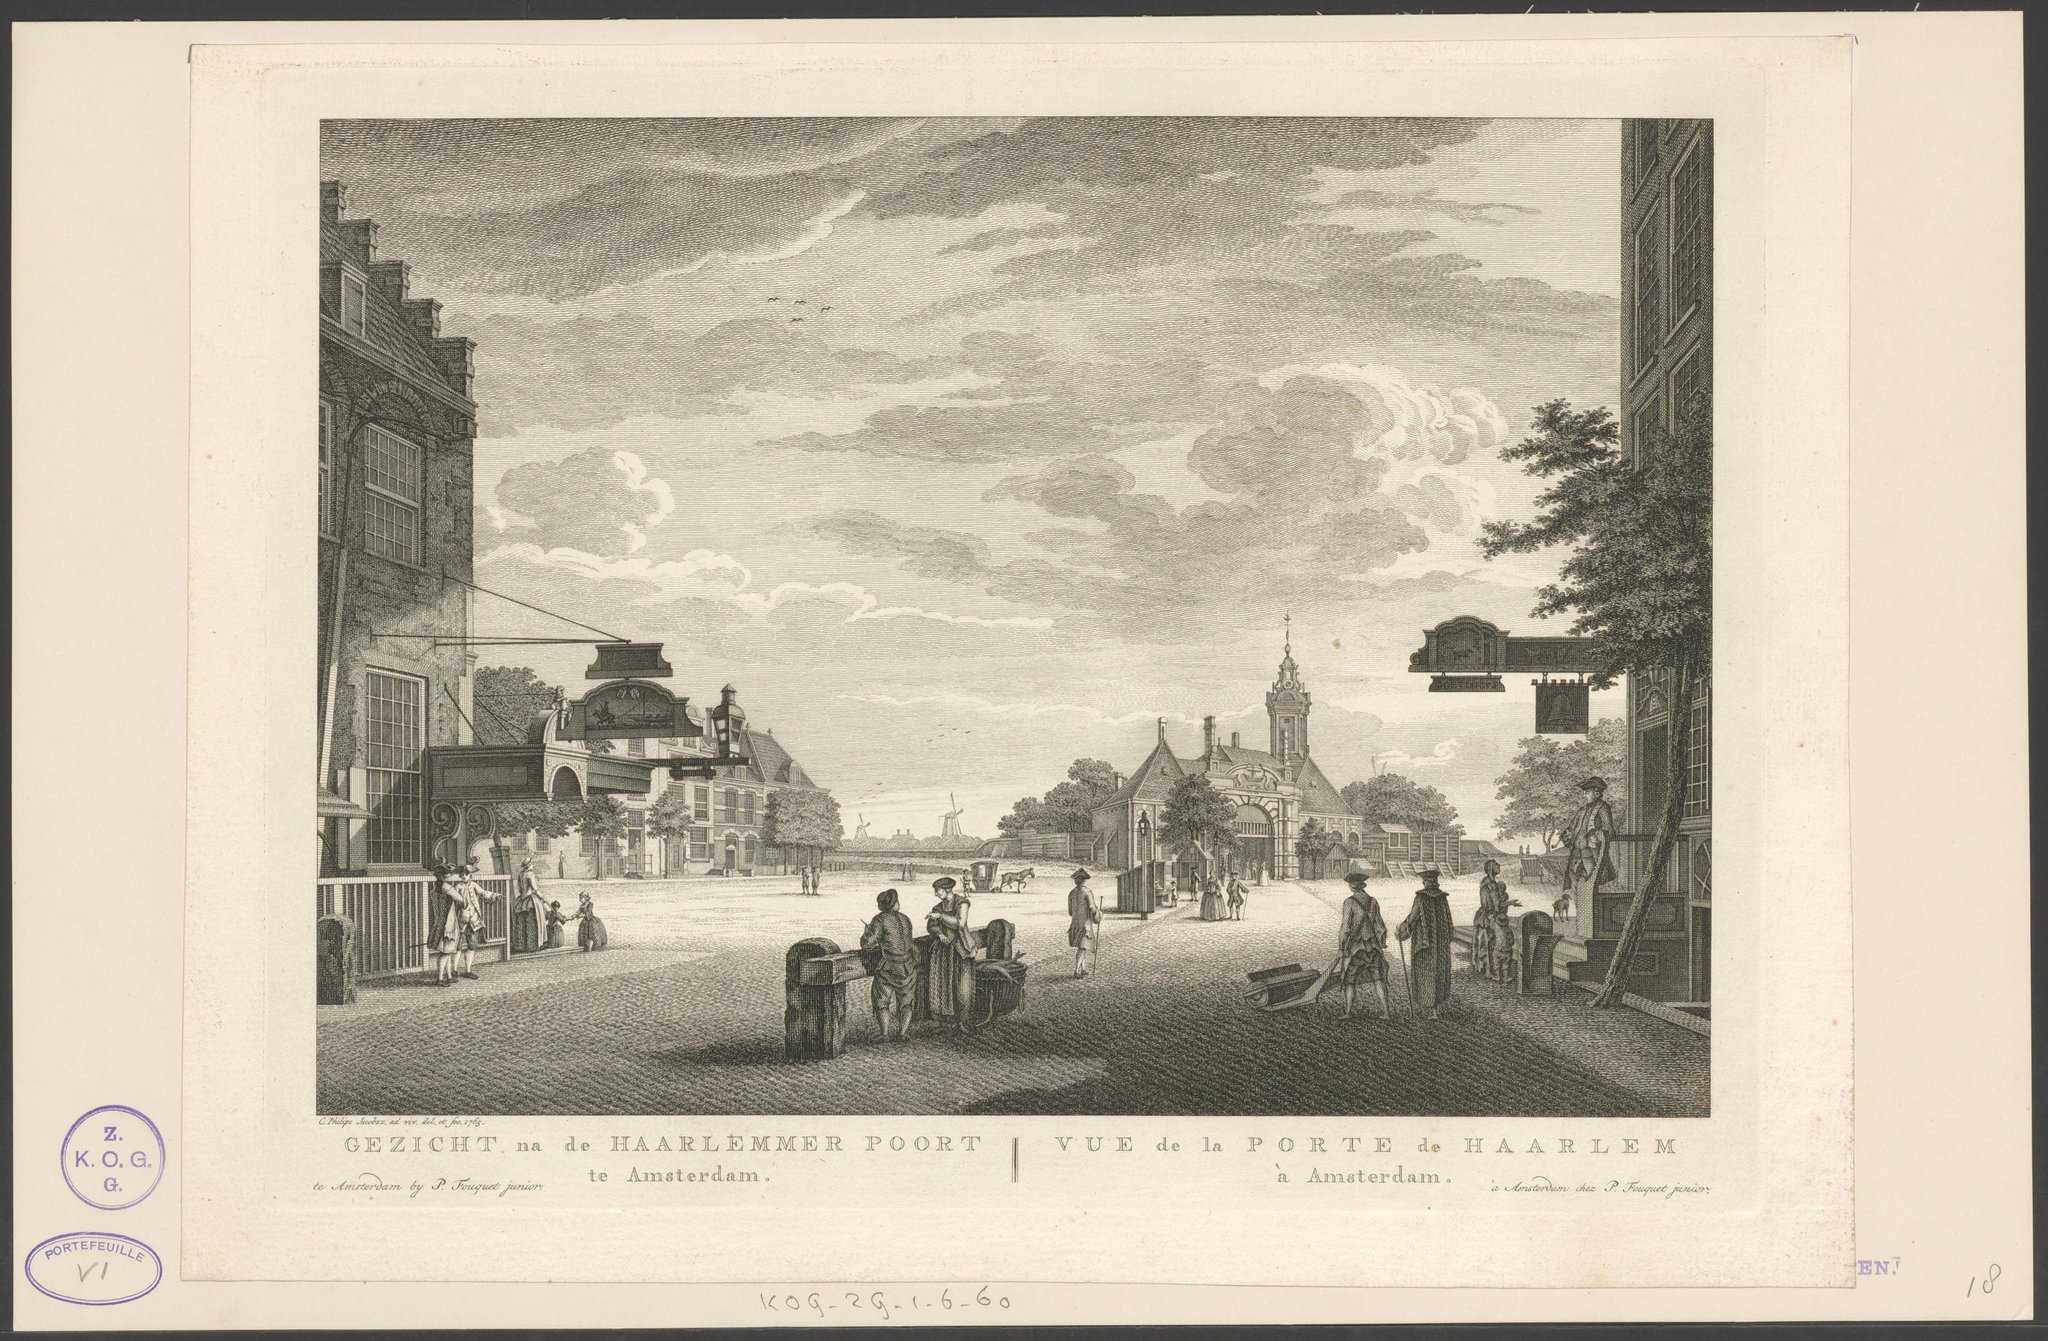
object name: print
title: Gezicht na de Haarlemmer Poort te Amsterdam / Vue de la Porte de Haarlem à Amsterdam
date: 1760-1783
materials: paper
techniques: engraving, etching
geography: amsterdam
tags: village street, city-gate, amsterdam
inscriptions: stamp, collector's mark: Lugt 1641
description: Deze prent is ook gebruikt in de zogenaamde Atlas van Fouquet.* Pierre Fouquet gaf vanaf 1760 stadsgezichten van Amsterdam - naar tekeningen van verschillende kunstenaars, gemaakt door verschillende prentmakers - uit. Deze prenten werden aanvankelijk los of in series verkocht. Zoals toen gebruikelijk kon de koper de prenten zelf laten inbinden. Hiertoe gaf Fouquet tussen 1778 en 1783 een titelblad, plattegrond en inhoudsopgave van de tot dusver 100 uitgegeven prenten uit (1). Gezien de inhoud afhankelijk was van wat de koper had verzameld verschilt de inhoud van de verschillende bewaarde Fouquetatlassen onder deze titel sterk. Ook zijn er exemplaren bekend waar tevens andere prenten aan zijn toegevoegd. Omdat er behoefte bleek aan uitleg bij de platen werd in 1783 een nieuwe versie van de atlas uitgegeven, aangevuld met tekst en twee prenten. De aangegeven volgorde veranderde maar de platen van de al eerder uitgegeven prenten bleven ongewijzigd. Deze uitgave werd in opdracht van Fouquet gedrukt bij Daniël Jean Changuion en Petrus den Hengst (2). Een tiental platen werd bijgewerkt en verscheen, met nieuw impressum, in het vervolg van Wagenaars geschiedenis van Amsterdam, uitgeven door Petrus Conradi en Folkert van der Plaats (3). Een aantal jaar na het overlijden van Fouquet kwam Evert Maaskamp met een nieuwe uitgave van de atlas, met verbeterde tekst en toevoeging van twee prenten. Op alle platen verwijderde hij het oude en liet hij zijn eigen impressum zetten (4). De huidige staat van de prent komt voor in exemplaren van de onder (1) en (2) genoemde werken. * Onder de Atlas van Fouquet of Fouquetatlas verstaan we de hieronder vermelde publicaties (1), (2) en (4). (1). Afbeeldingen van de wyd-vermaarde koopstad Amsterdam benevens des zelvs voornaamste gebouwen en gezigten alle naar het leeven getekend / Receuil des edifices les plus considerables et des plus belles vues, de la fameuse ville d'Amsterdam, dessinées d'après nature. Amsterdam: Pierre Fouquet, 1778-1783. (2). Nieuwe atlas, van de voornaamste gebouwen en gezigten der stad Amsterdam, met derzelver beknopte beschryvingen. 2 delen. Amsterdam: Daniël Jean Changuion en Petrus den Hengst [in opdracht van Pierre Fouquet], 1783. (3). Stijl, Simon. Amsterdam, in zyne geschiedenissen, voorregten, koophandel, gebouwen, kerkenstaat, schoolen, schutterye, gilden en regeeringe, beschreeven. Om te dienen ten vervolge op het werk van Jan Wagenaar (…). 10 delen. Amsterdam en Harlingen: Petrus Conradi en Folkert van der Plaats, 1788-1801. (4). Nieuwe atlas, van de voornaamste gebouwen en gezigten der stad Amsterdam. Met derzelver beknopte beschryvingen. Amsterdam: Evert Maaskamp, 1805. * Het aantal vermelde staten is gebaseerd op het aantal gevonden staten. Mogelijk zijn er meer staten van deze prent. Voor de tweede staat zie RP-P-AO-27-11B, en voor de derde bekende staat zie RP-P-OB-88.609. Daarop is de nummering van de huidige staat zichtbaar verwijderd.